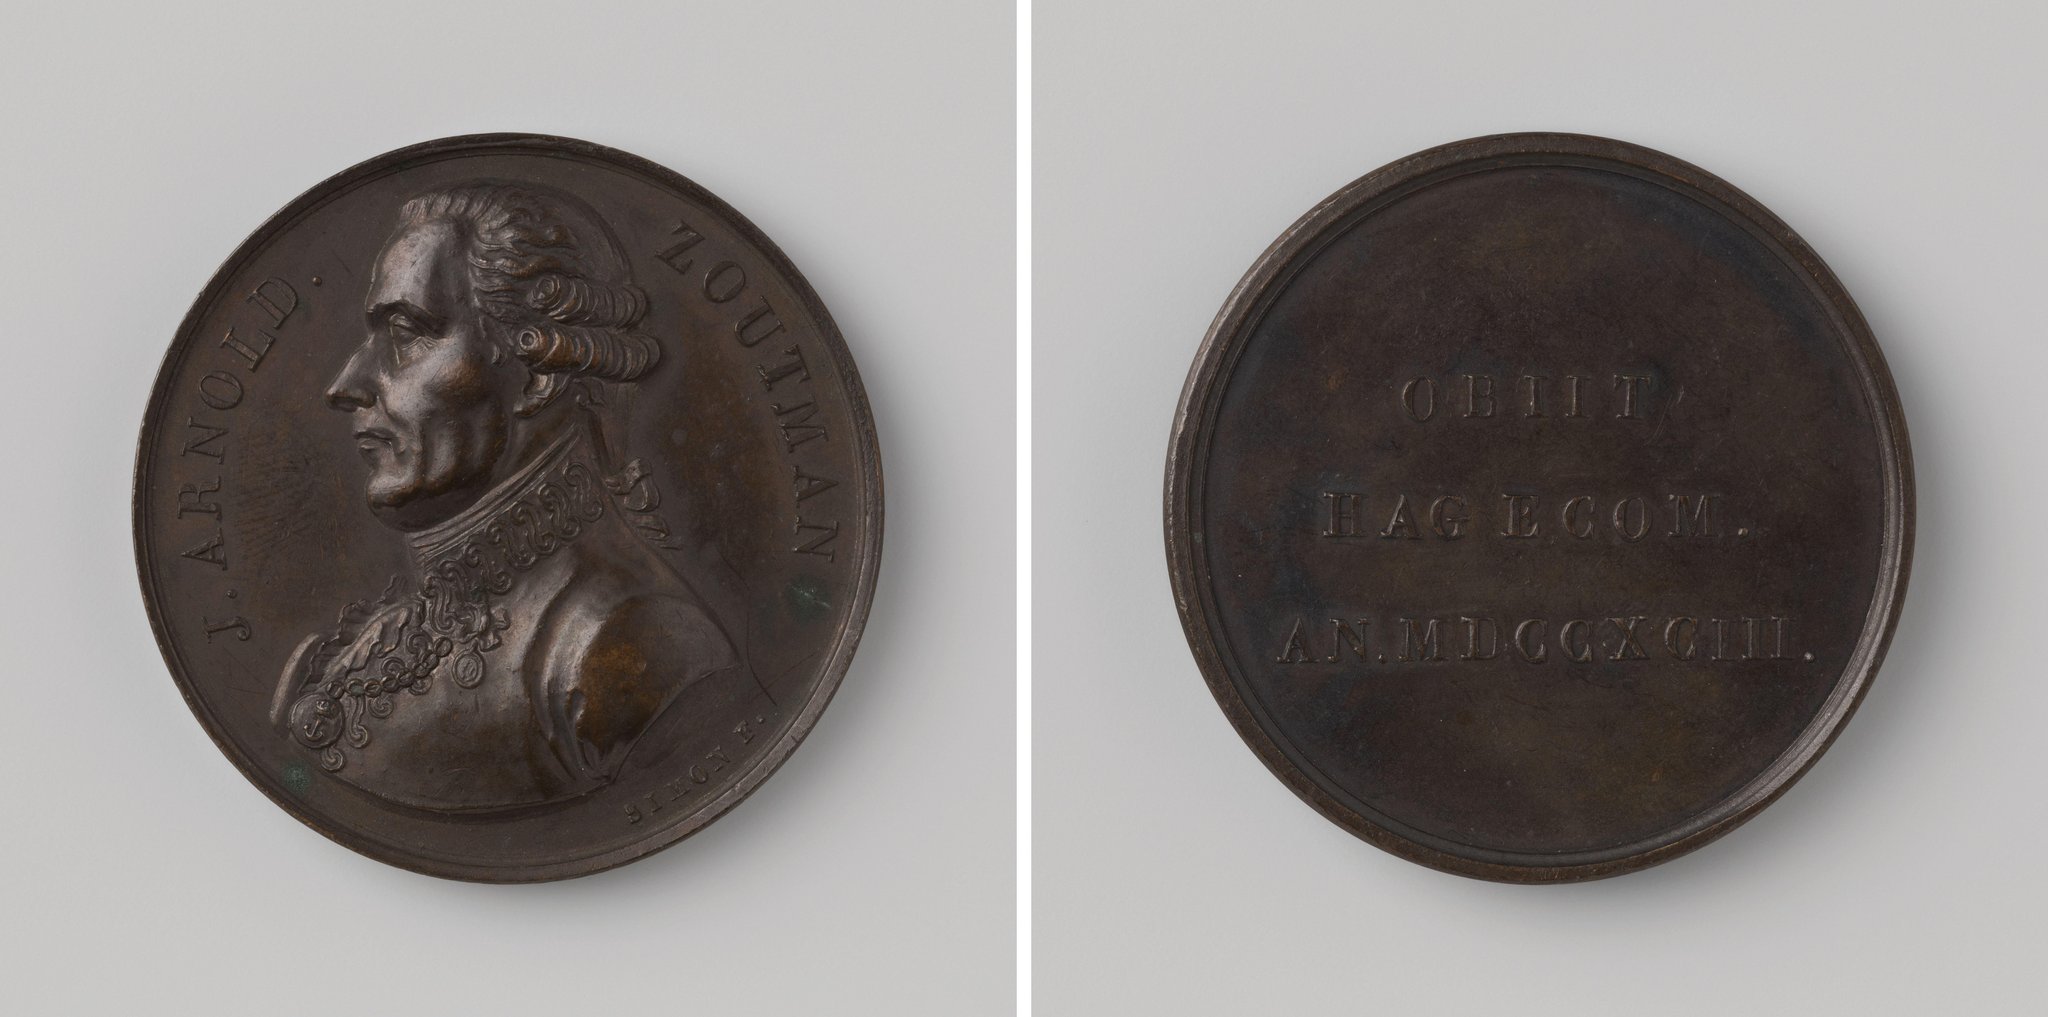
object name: history medal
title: Overlijden van luitenant-admiraal Johan Arnold Zoutman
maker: jean henri simon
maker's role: medailleur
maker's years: 1752-1834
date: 1816-1834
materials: bronze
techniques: striking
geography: brussels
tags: johan arnold zoutman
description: Bronzen penning. Voorzijde: borststuk man binnen omschrift. Keerzijde: opschrift